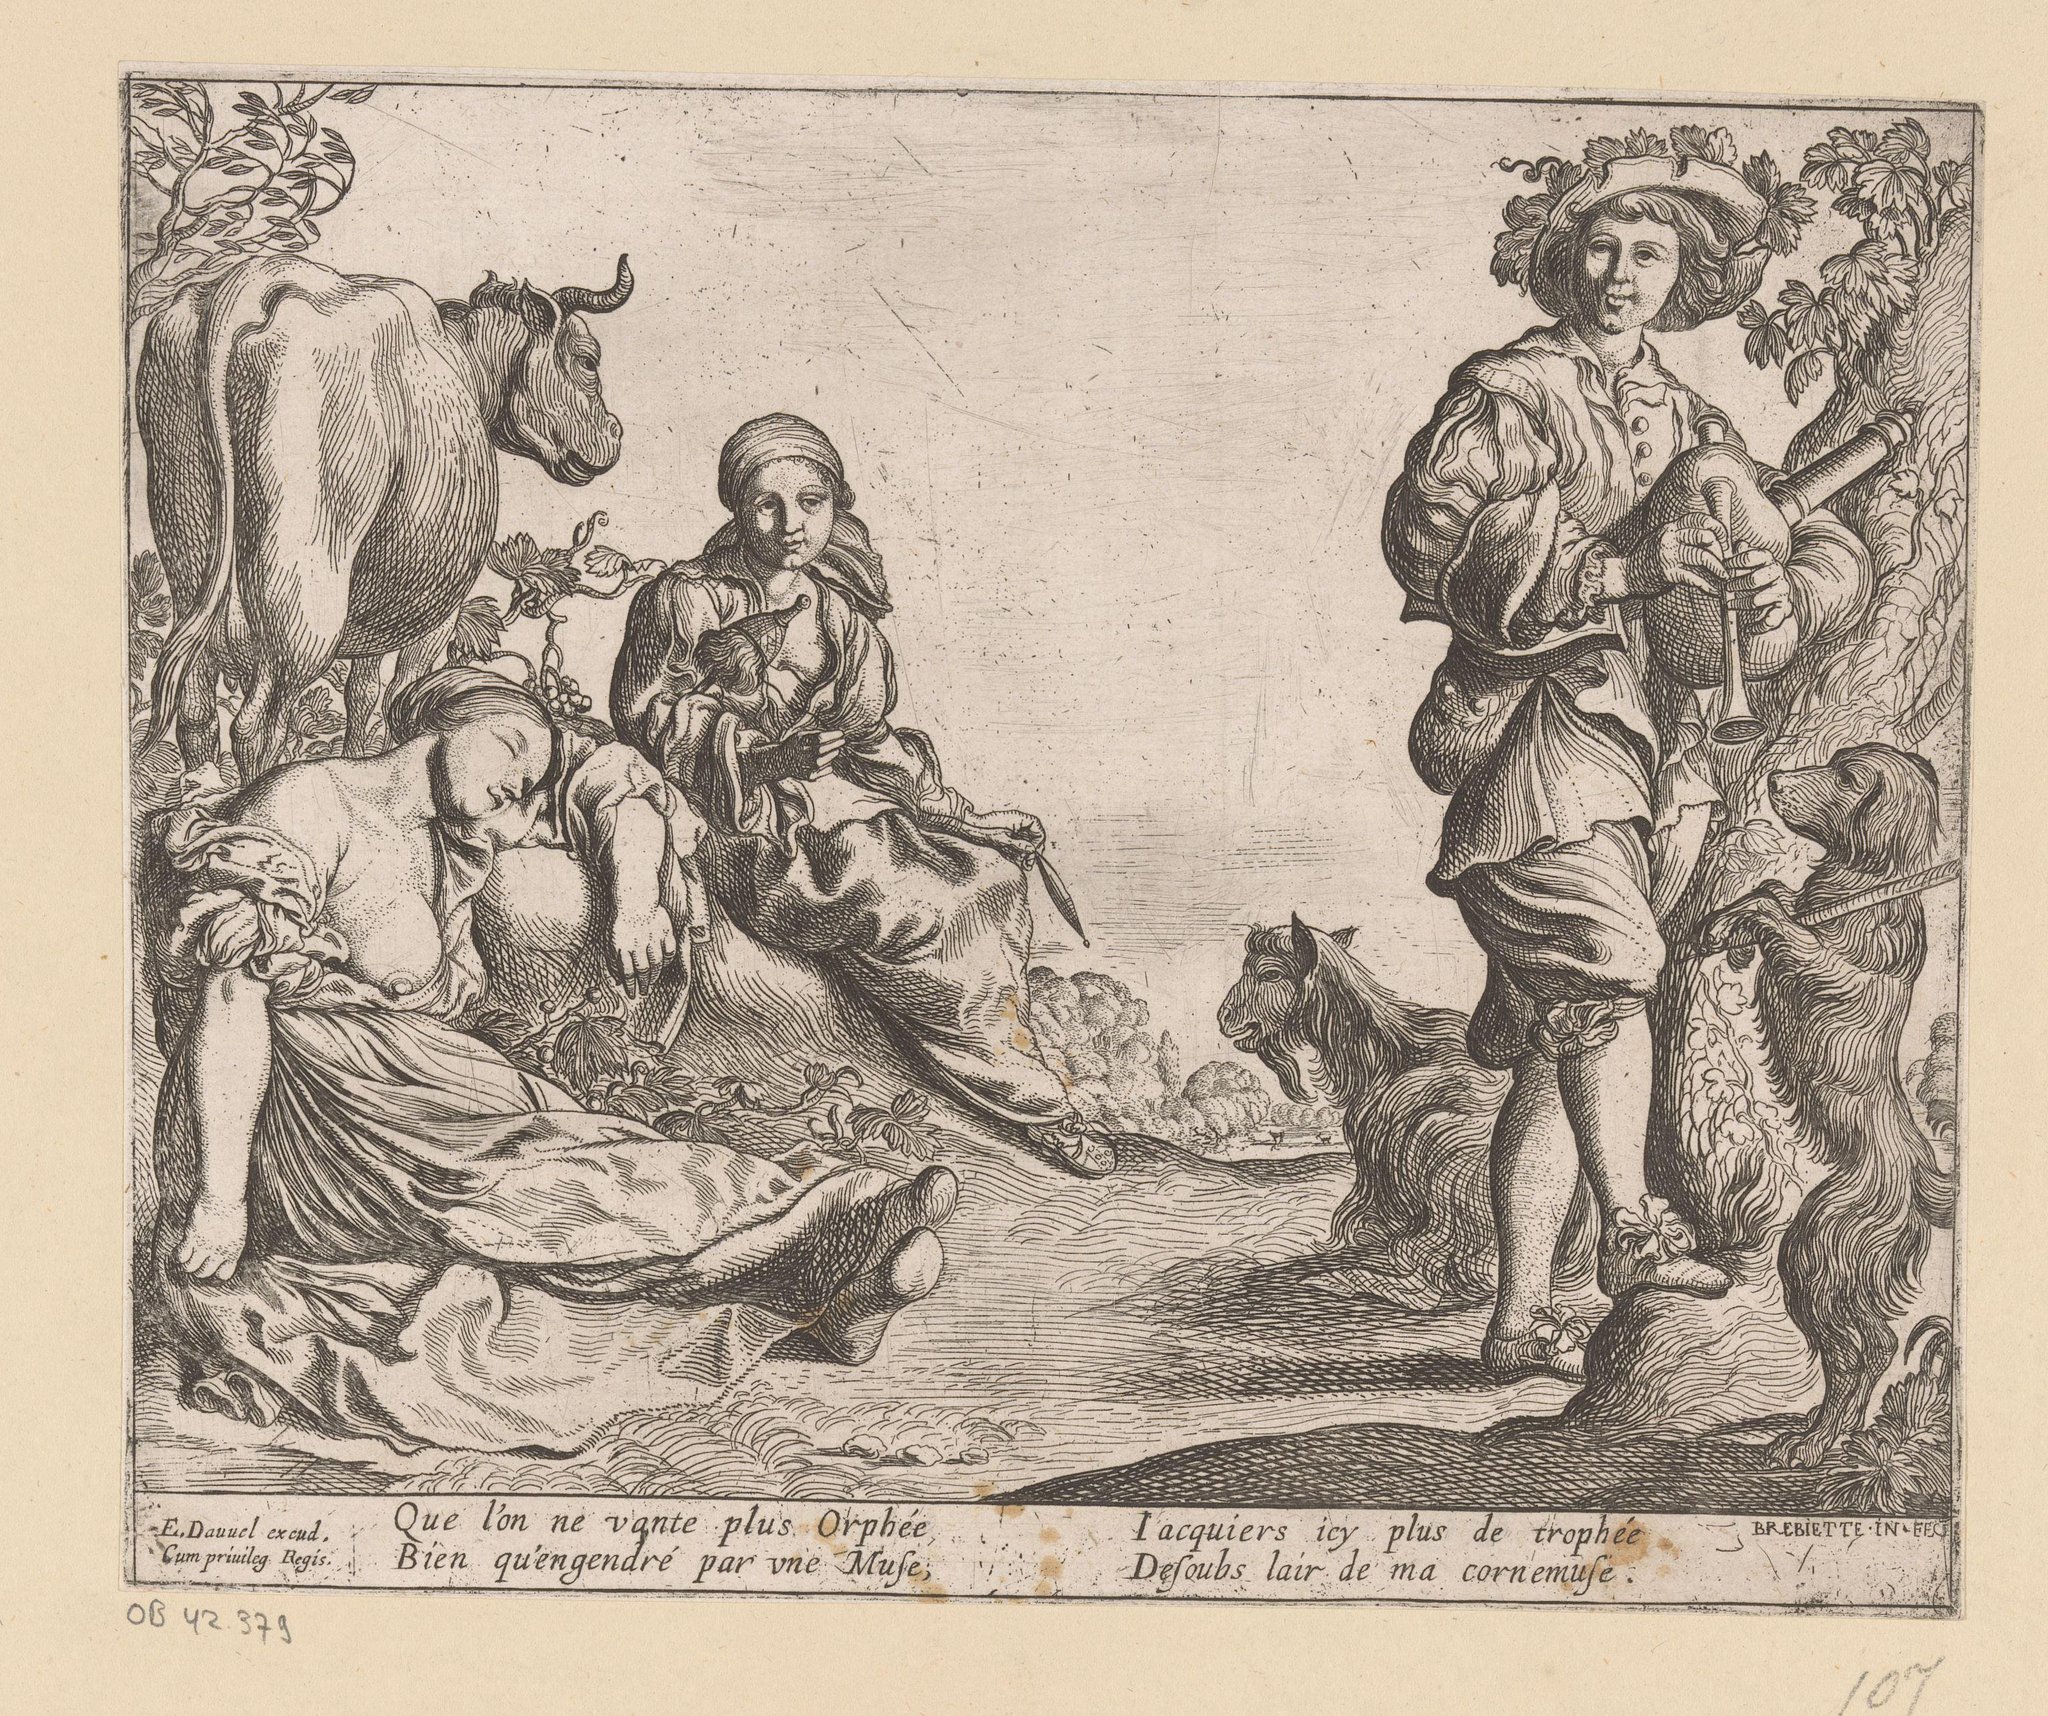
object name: print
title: Herder laat hond dansen bij een slapende en een spinnende herderin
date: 1608-1638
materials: paper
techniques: etching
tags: herding, herdsman, herdswoman, shepherd, shepherdess, cowherd, etc., bagpipe, musette, sleeping; unconsciousness, dog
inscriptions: collector's mark: Lugt 240